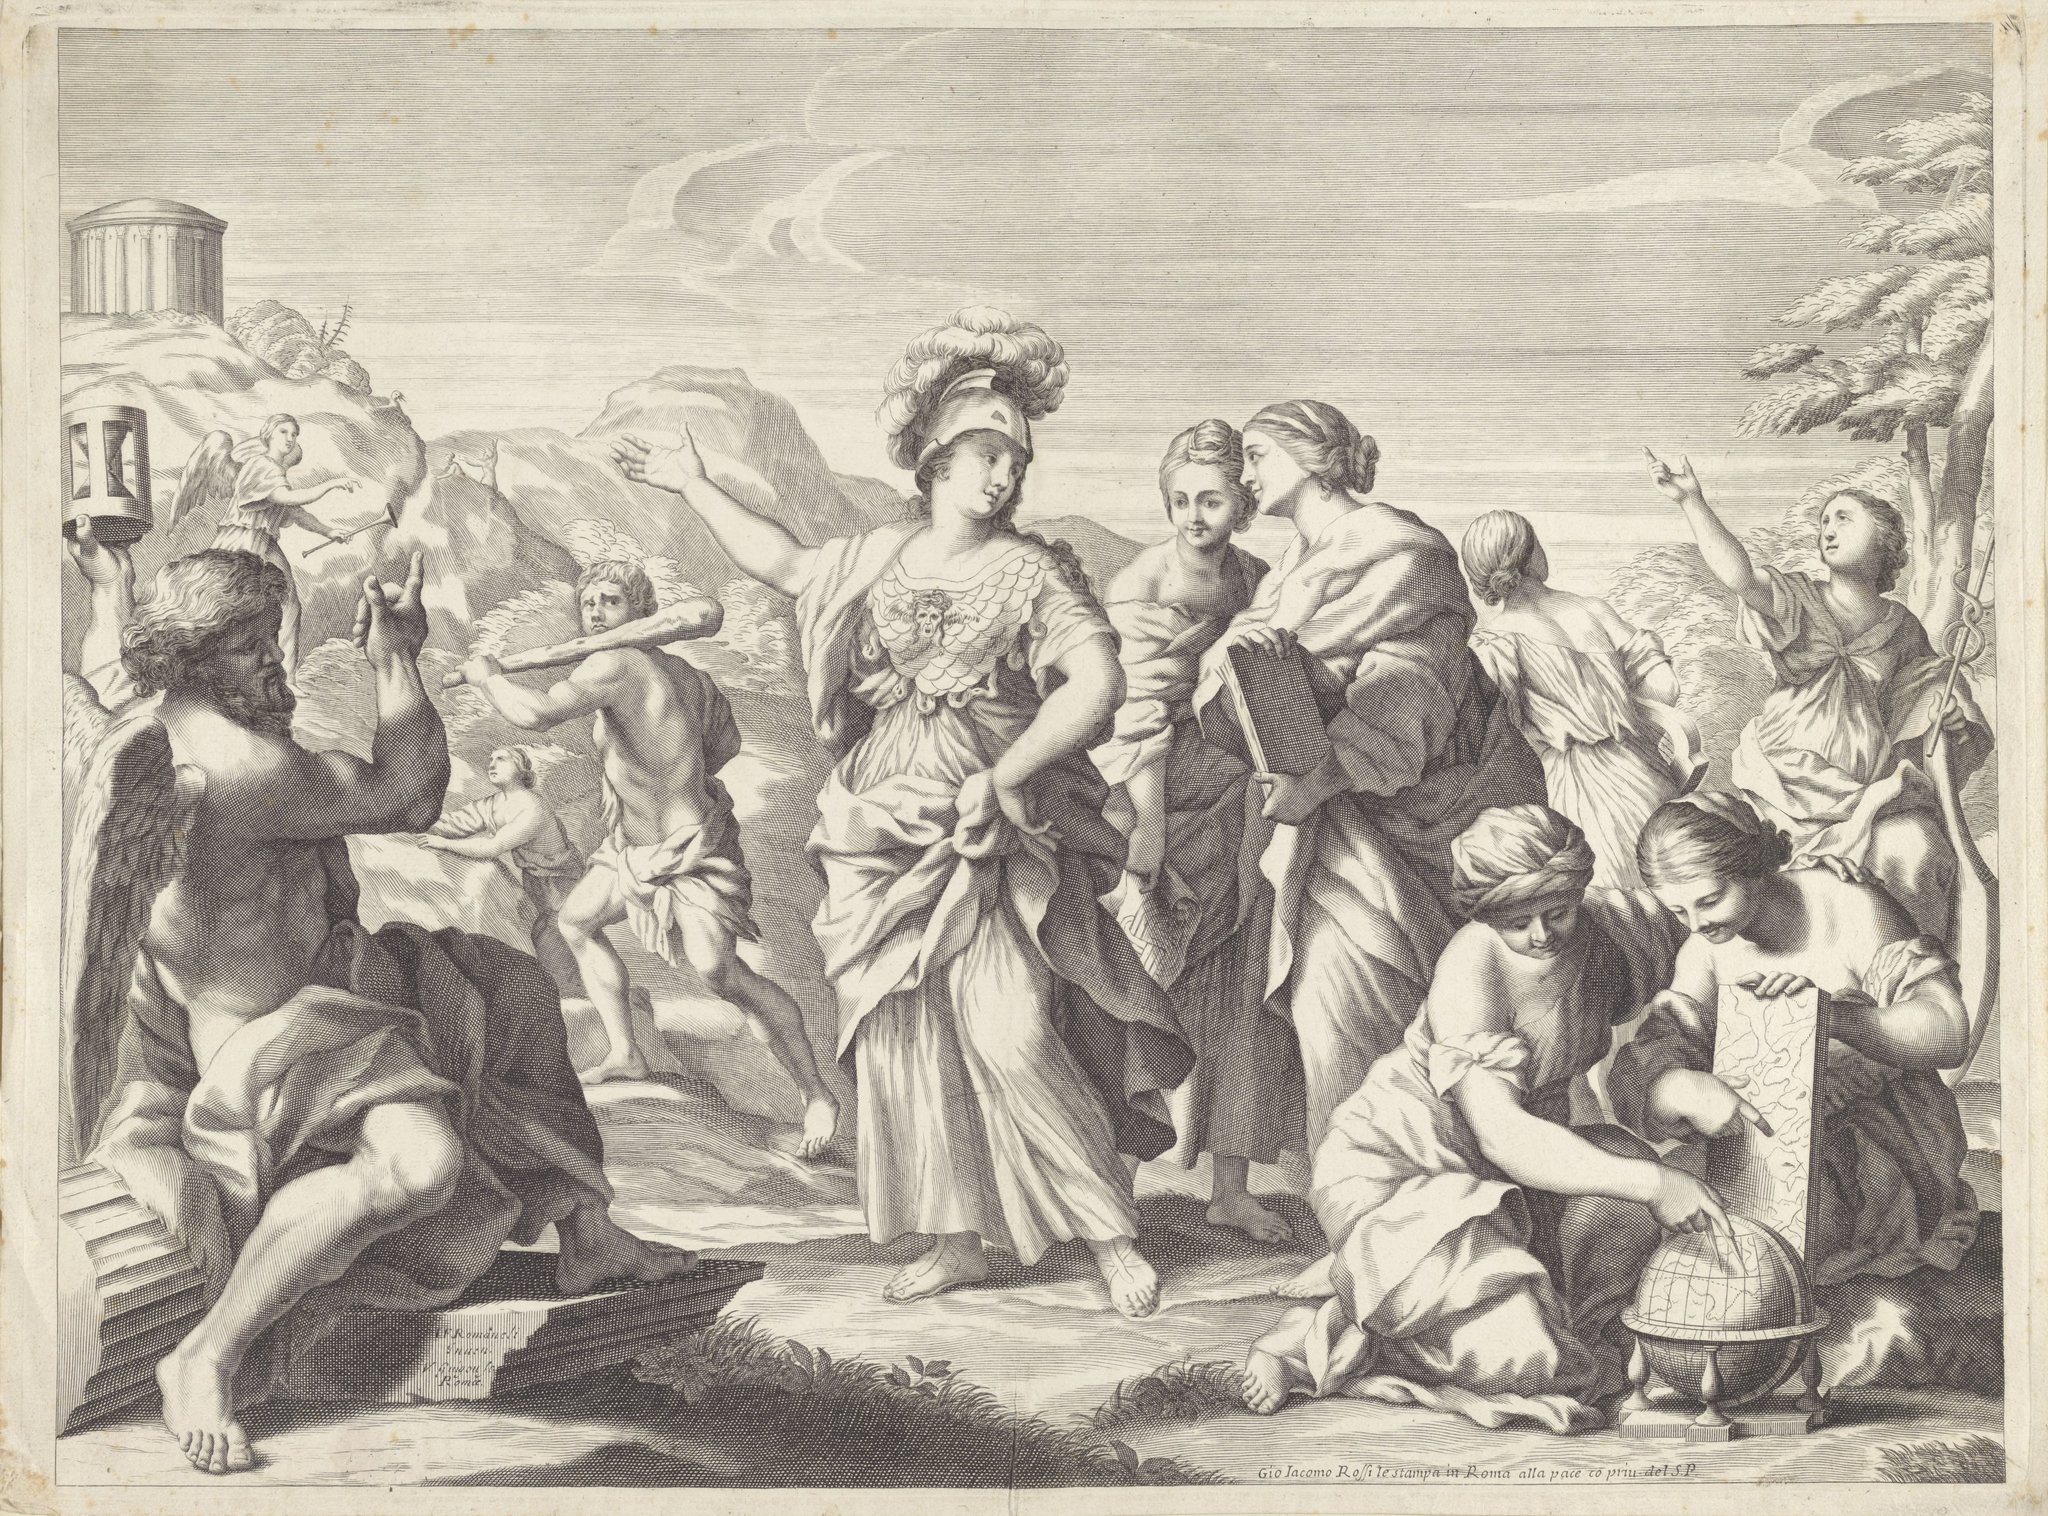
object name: print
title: Minerva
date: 1637-1691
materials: paper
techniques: engraving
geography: vatican city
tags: the muses acting together (as group) - attributes, (story of) minerva (pallas, athena), (story of the) muses; 'muse' (ripa), father time, man with wings and scythe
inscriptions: collector's mark: Lugt 240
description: Minerva staat in een landschap en wijst naar een ronde tempel op een heuvel. Naast Minerva staan en zitten de Muzen. Op de voorgrond links zit Vadertje Tijd.